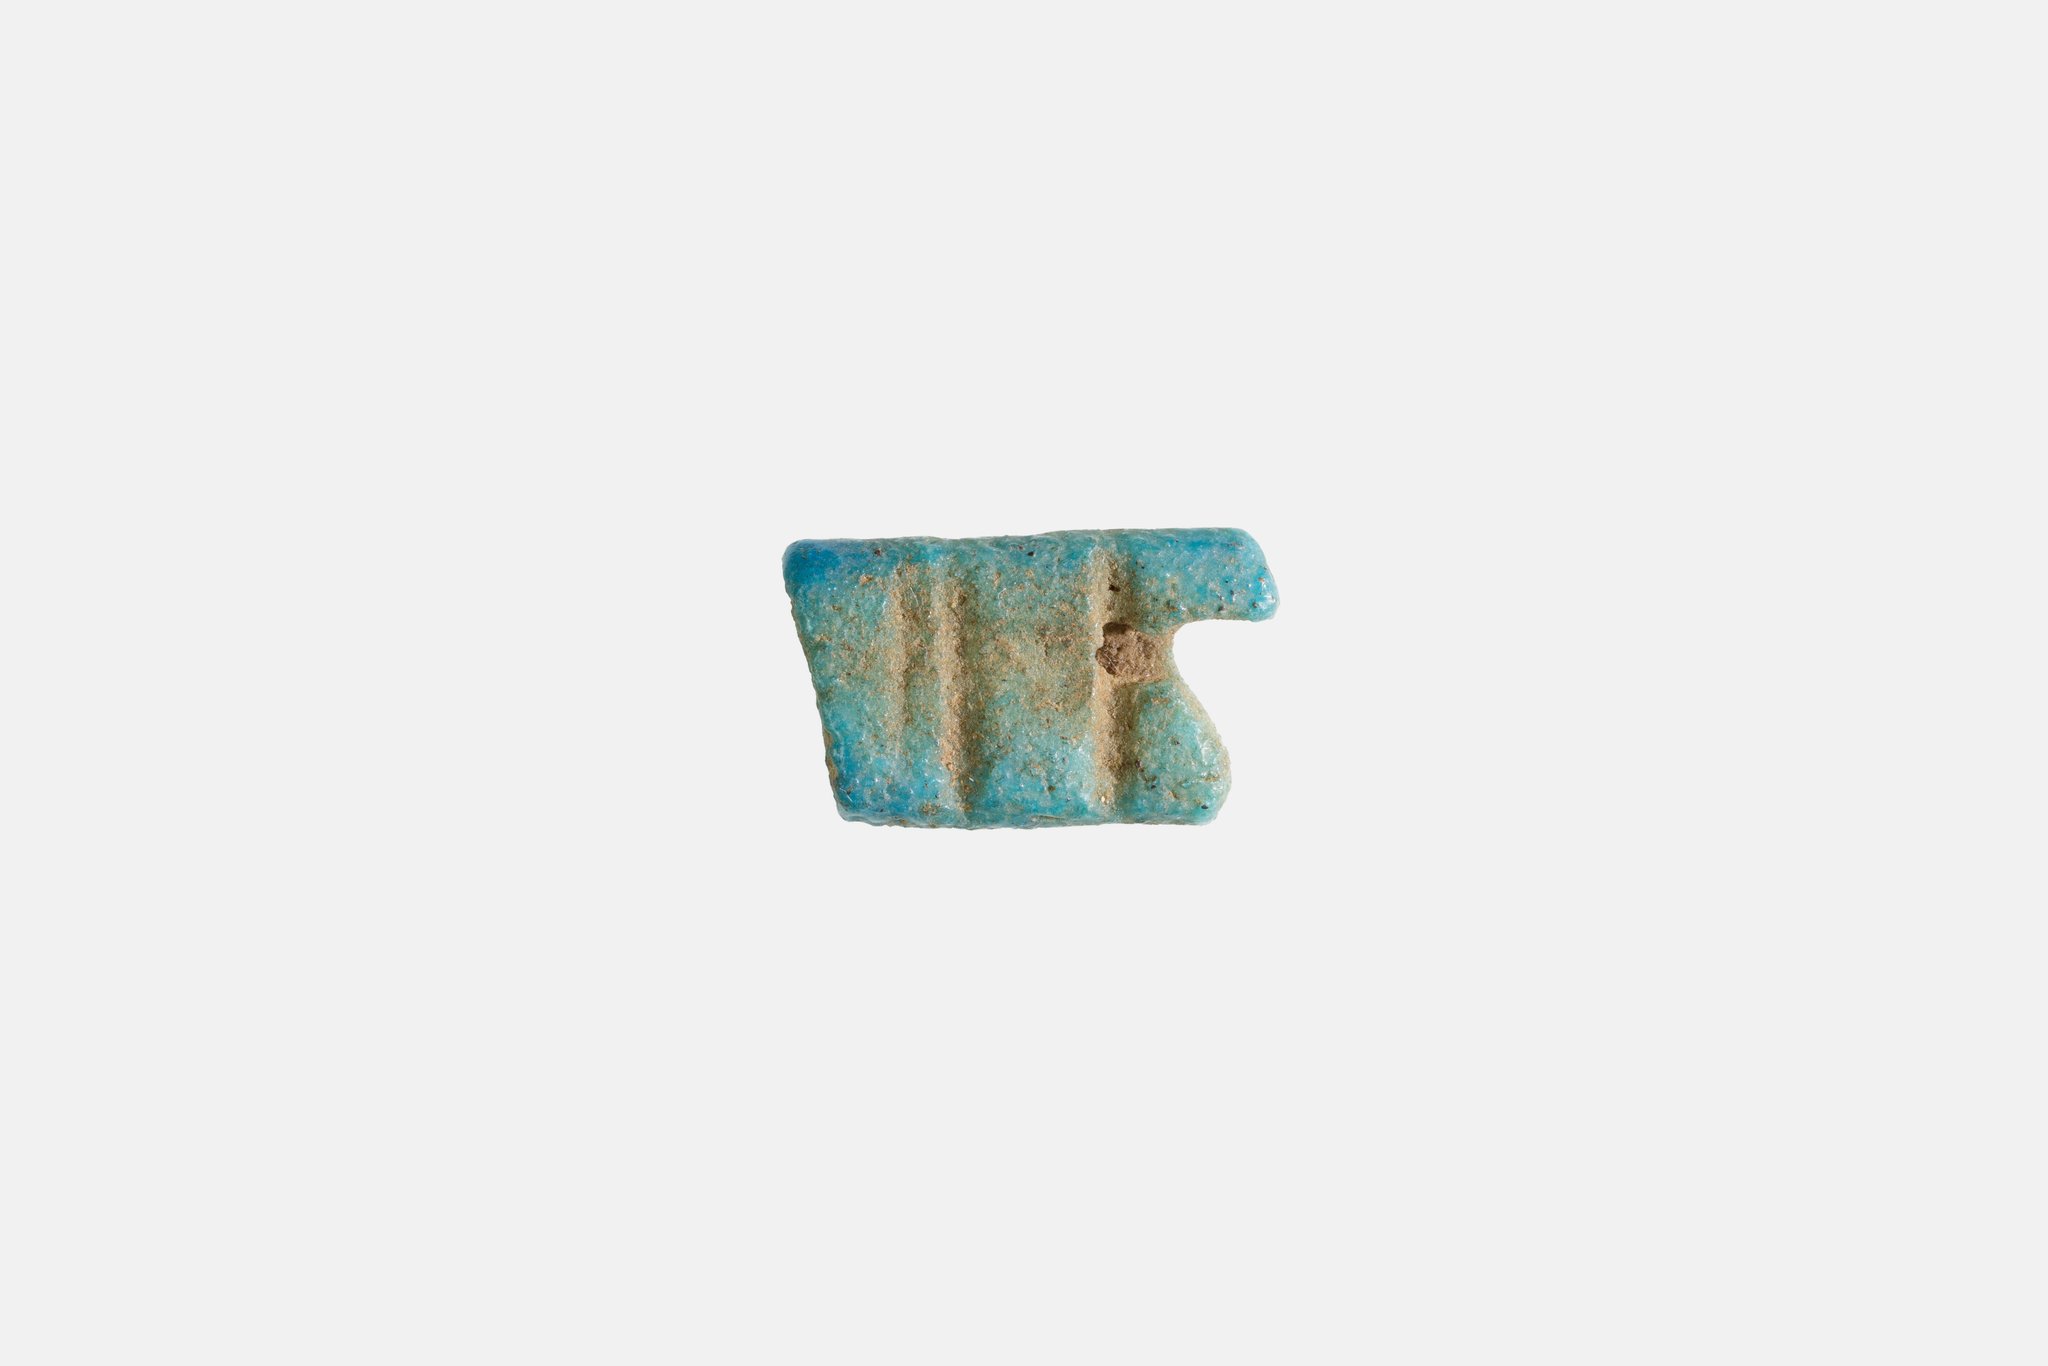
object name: bead, broken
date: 1295-1070 BCE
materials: faience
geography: northern upper egypt